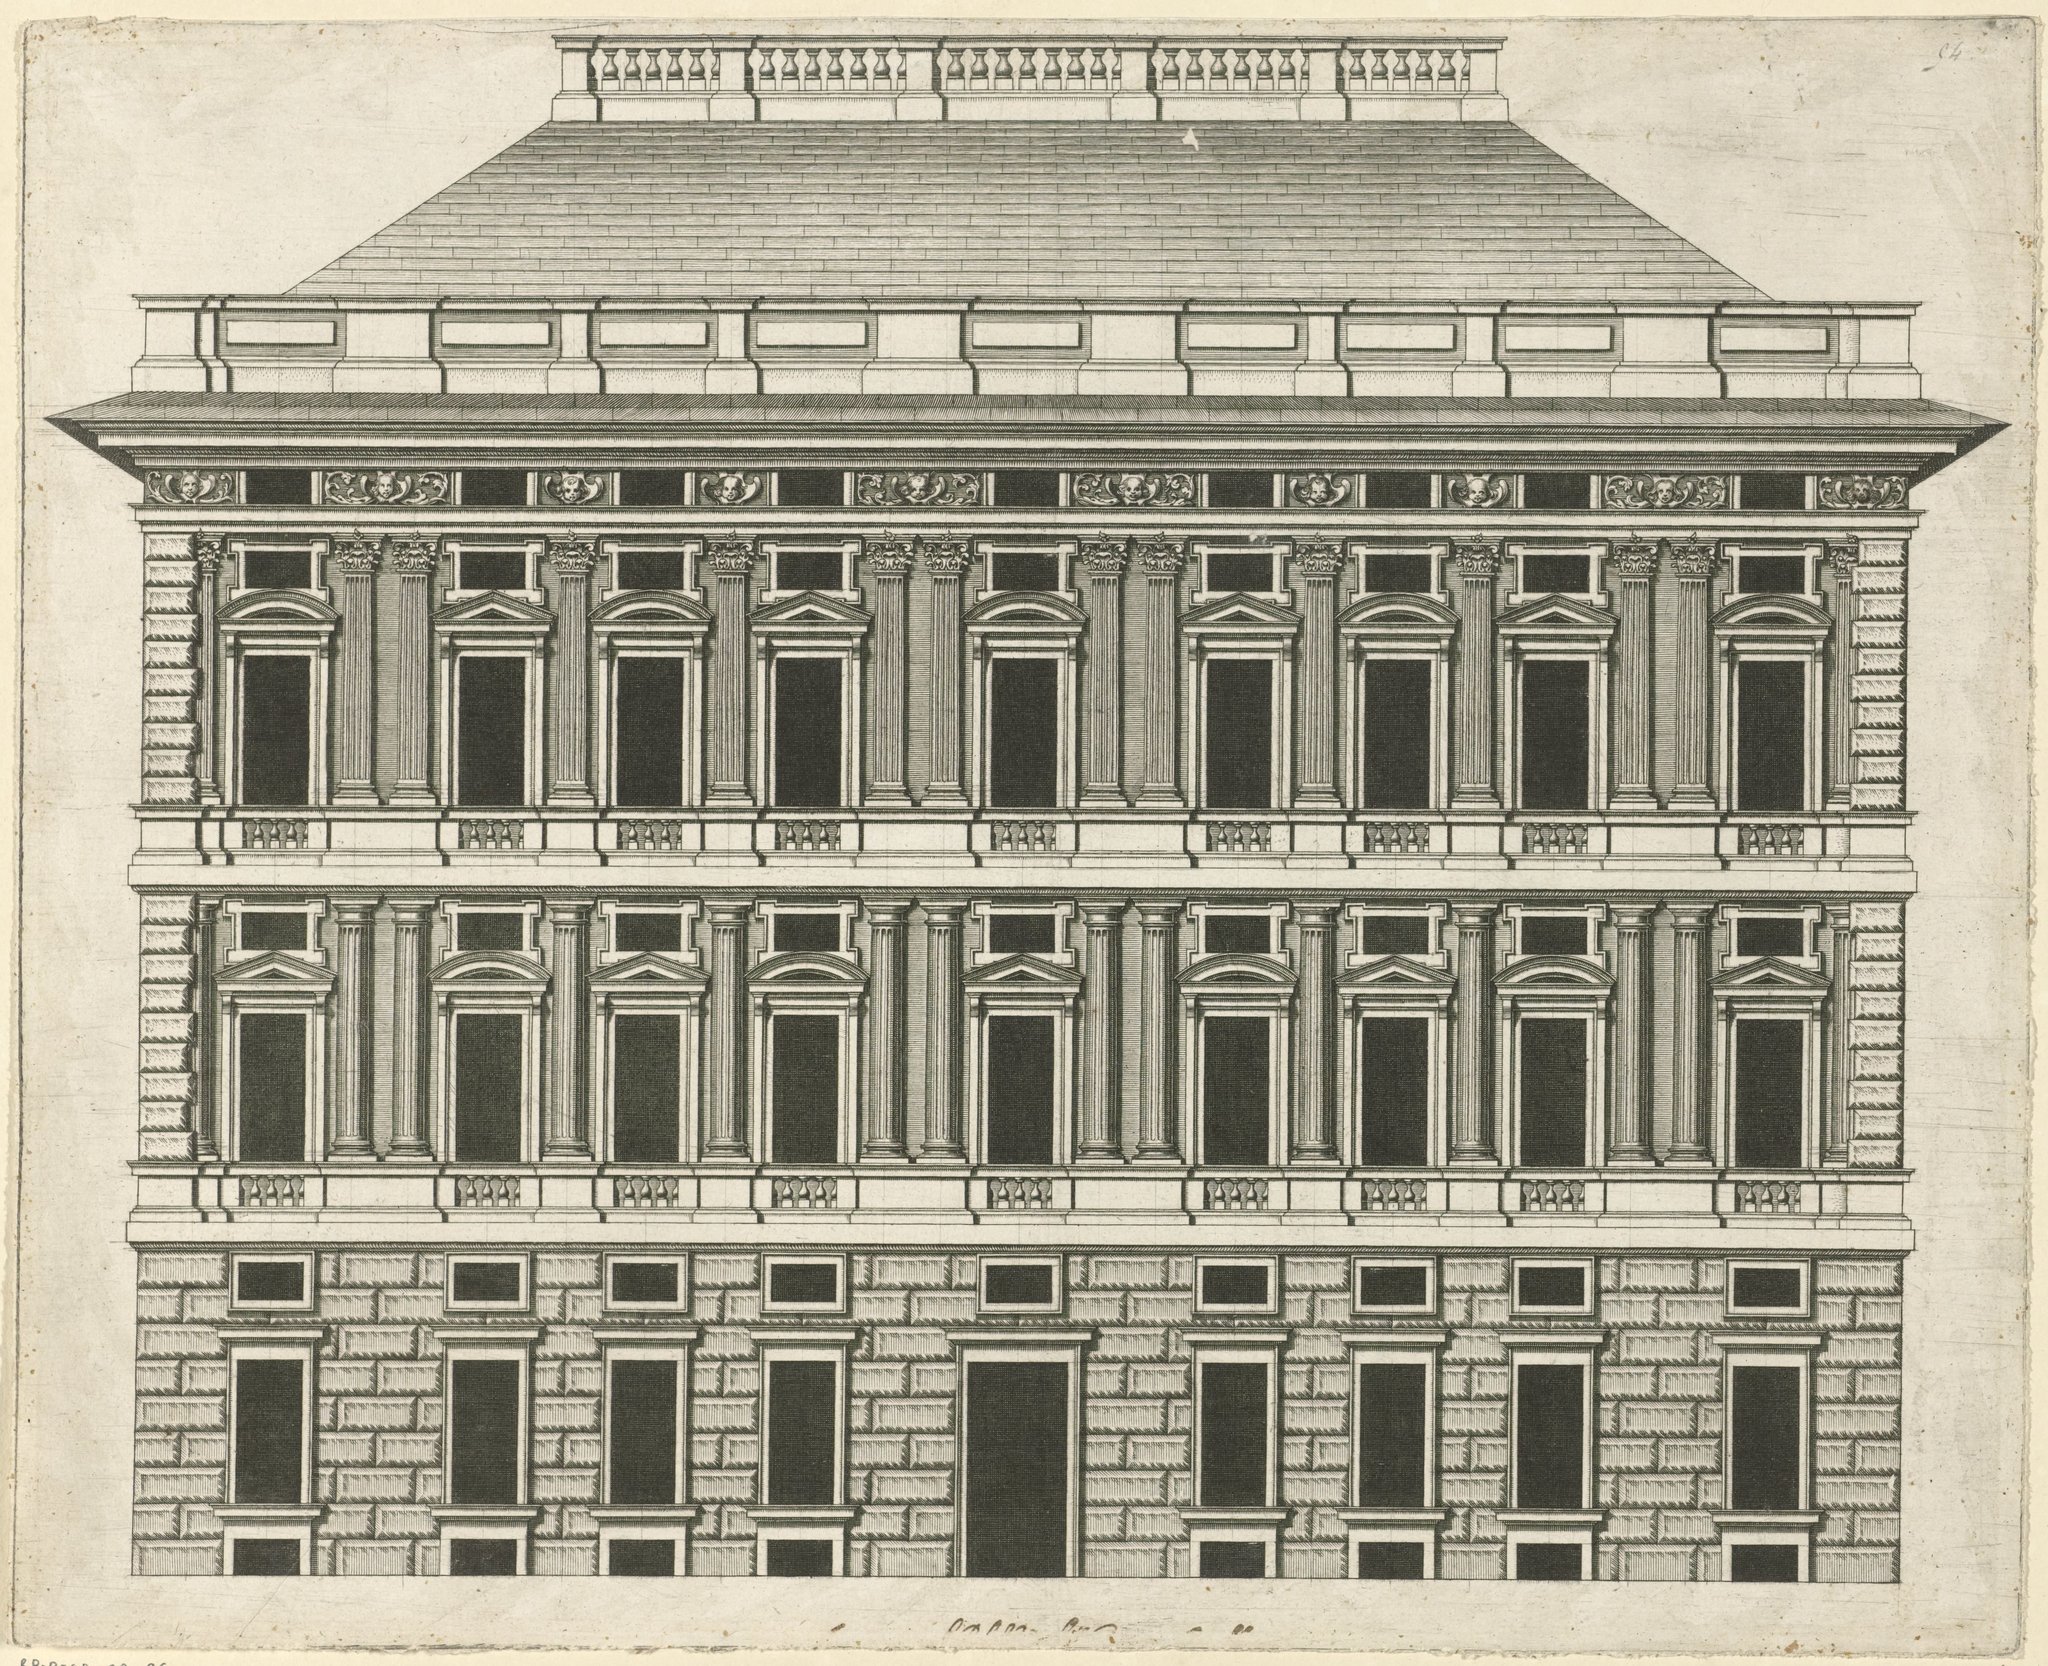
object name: print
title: Palazzo Patrone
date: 1622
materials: paper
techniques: engraving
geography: antwerp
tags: façade (of house or building)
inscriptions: collector's mark: Lugt 240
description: Voorgevel van Palazzo Patrone (Comando Militare Regionale Liguria), gelegen aan de largo della Zecca te Genua. Het palazzo werd tussen 1619 en 1623 gebouwd voor Giacomo Lomellini, doge van Genua.